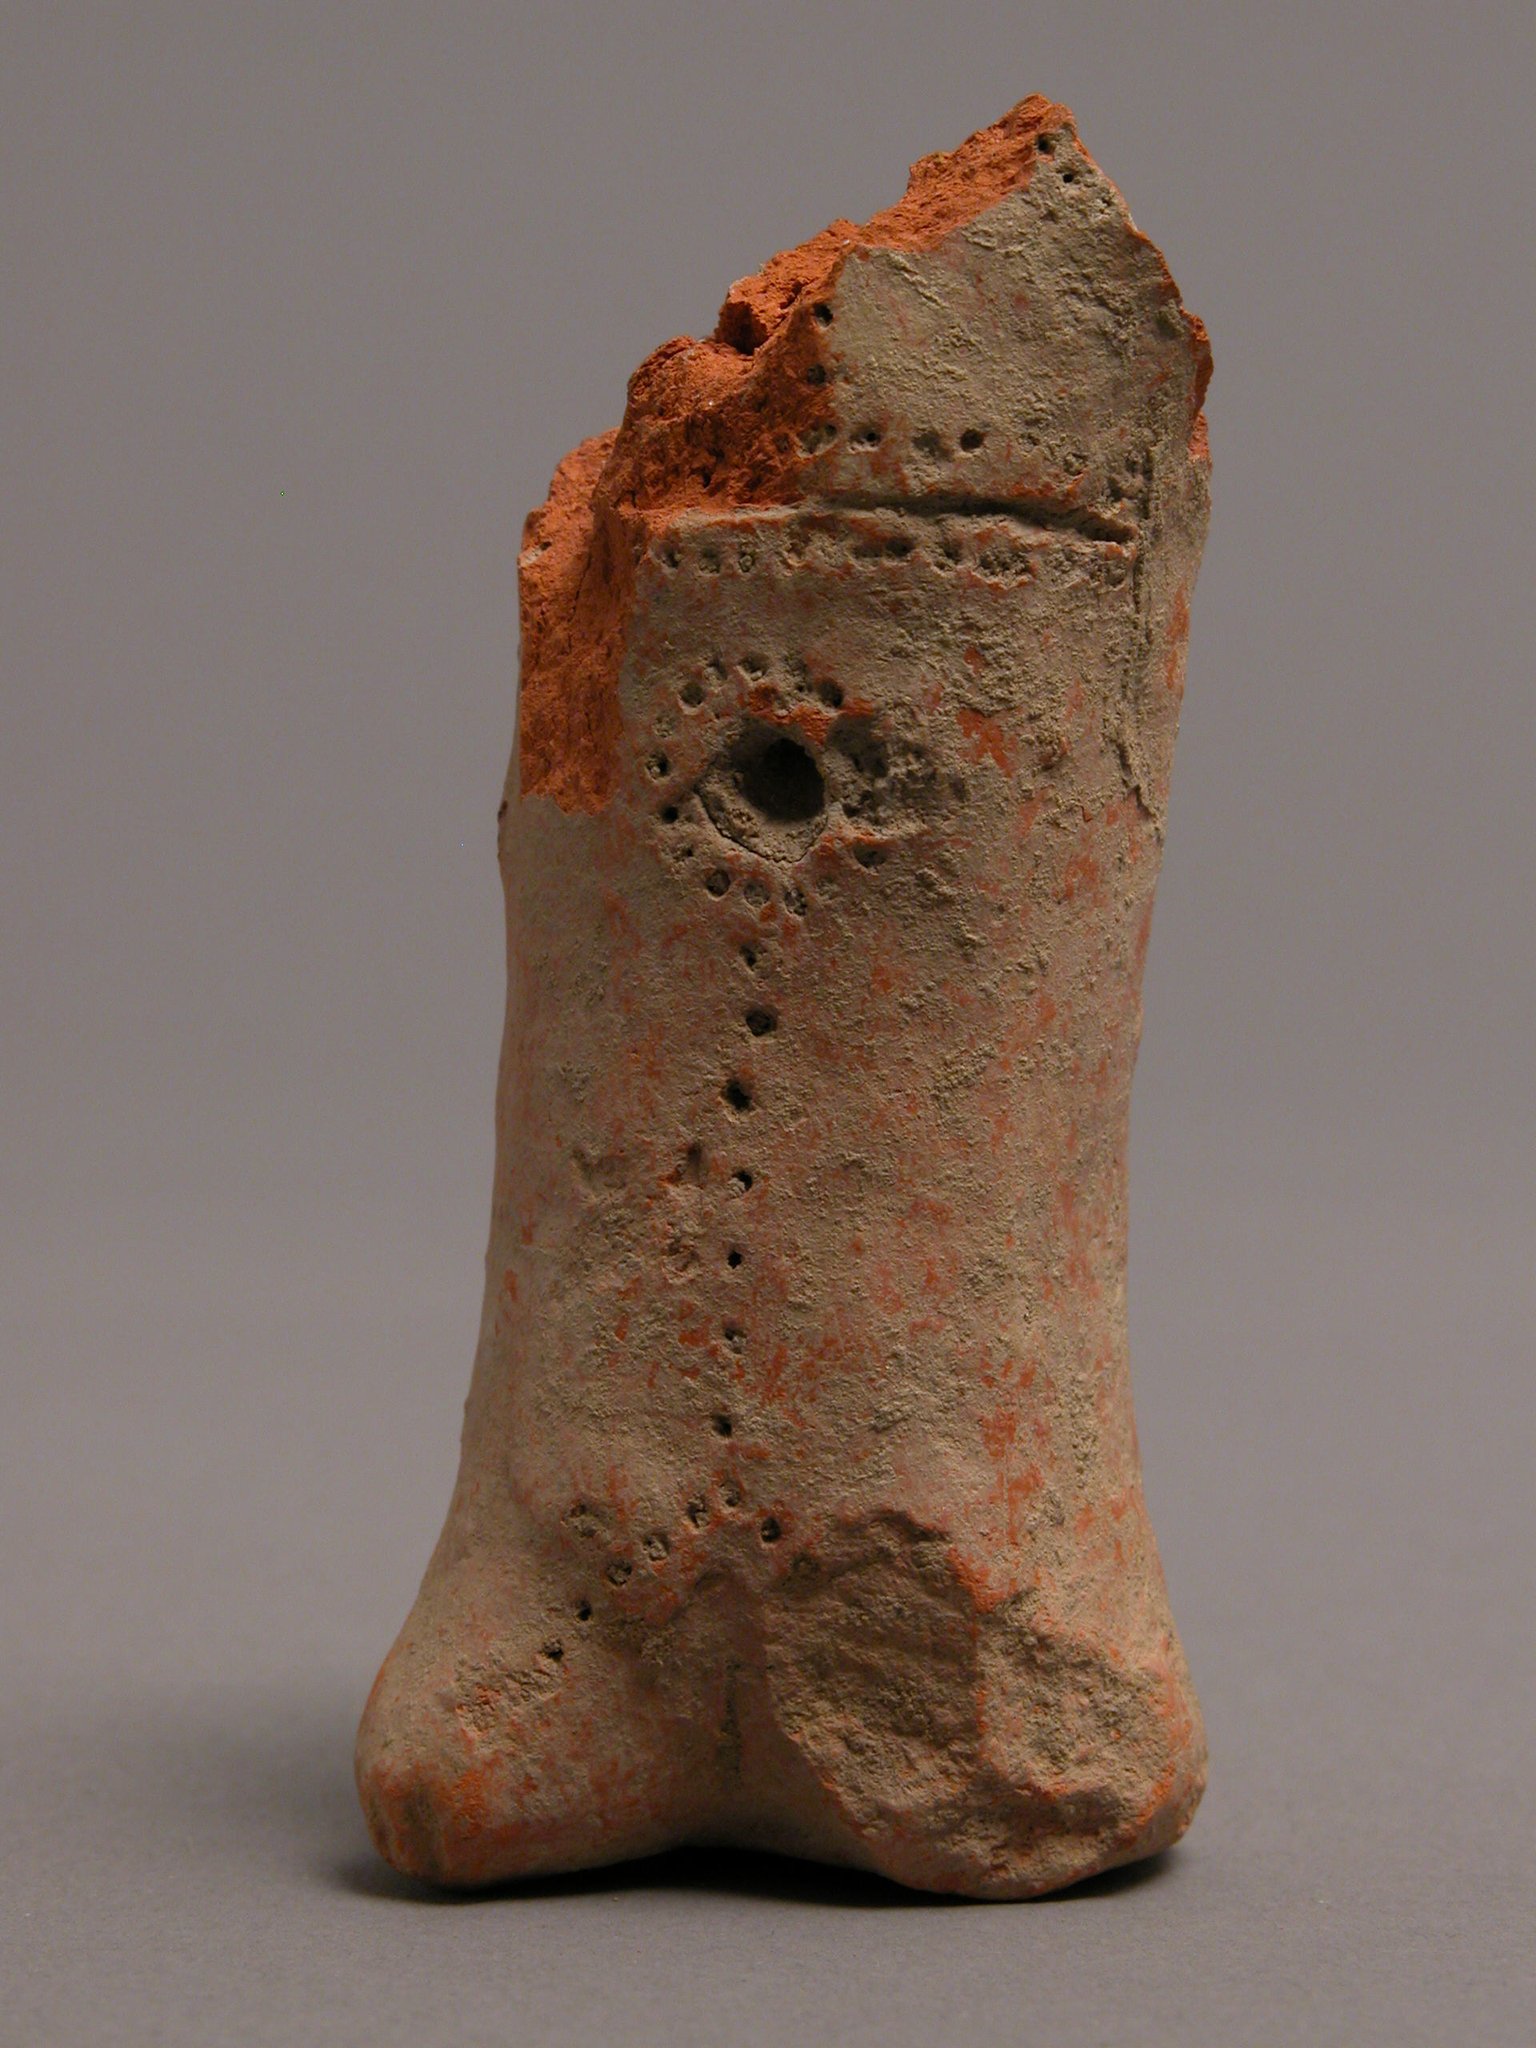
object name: statuette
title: Fragment of a Figure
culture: coptic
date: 301-700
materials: earthenware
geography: egypt